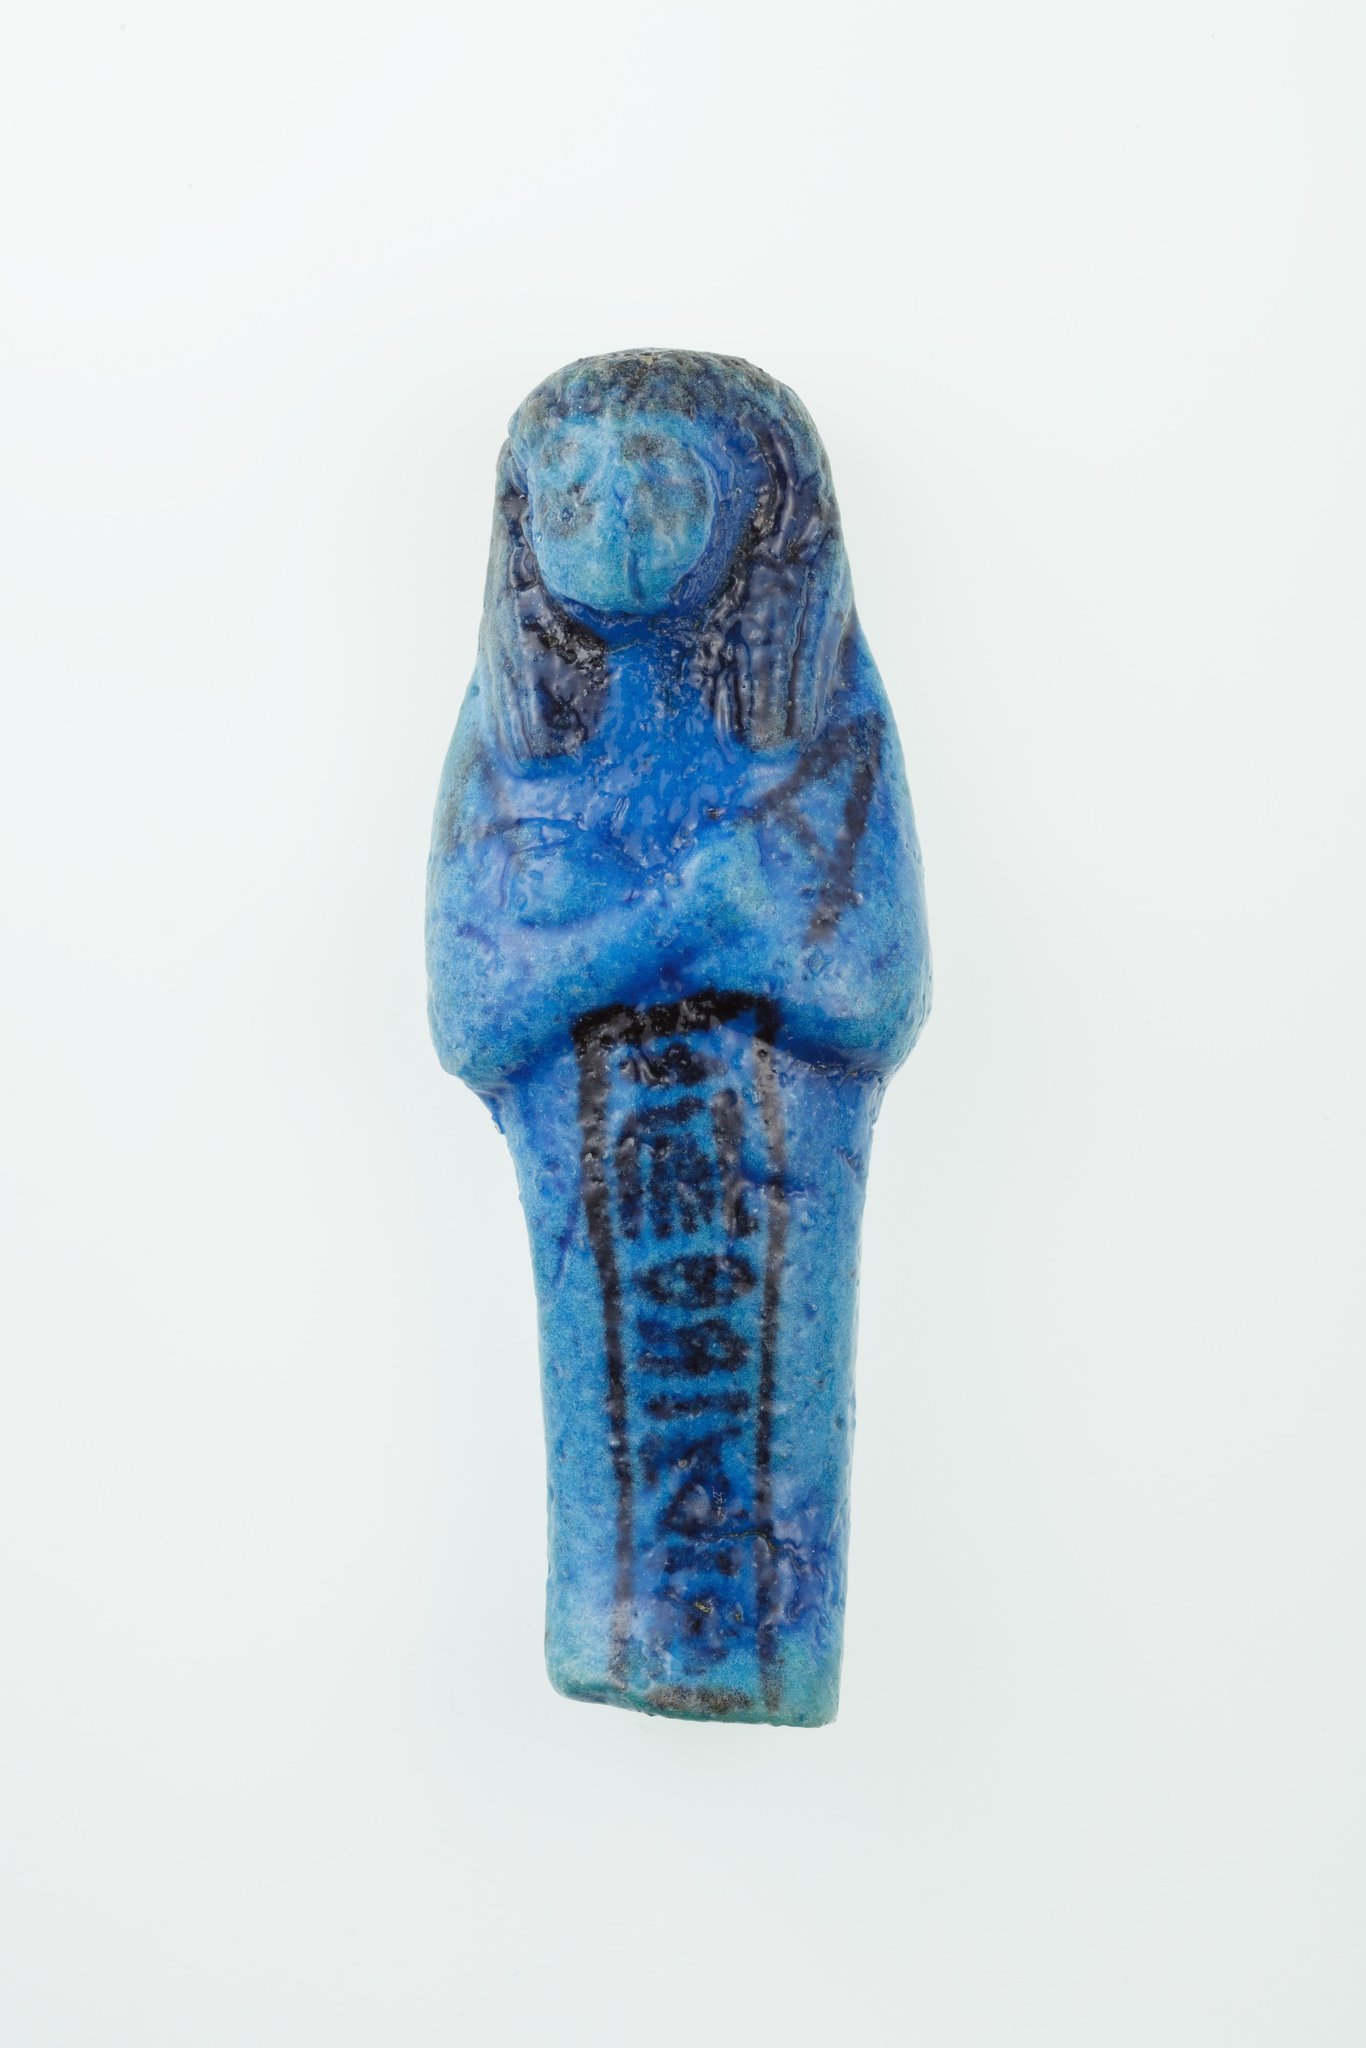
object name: shabti, worker, nauny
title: Worker Shabti of Nauny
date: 1050 BCE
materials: faience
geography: egypt